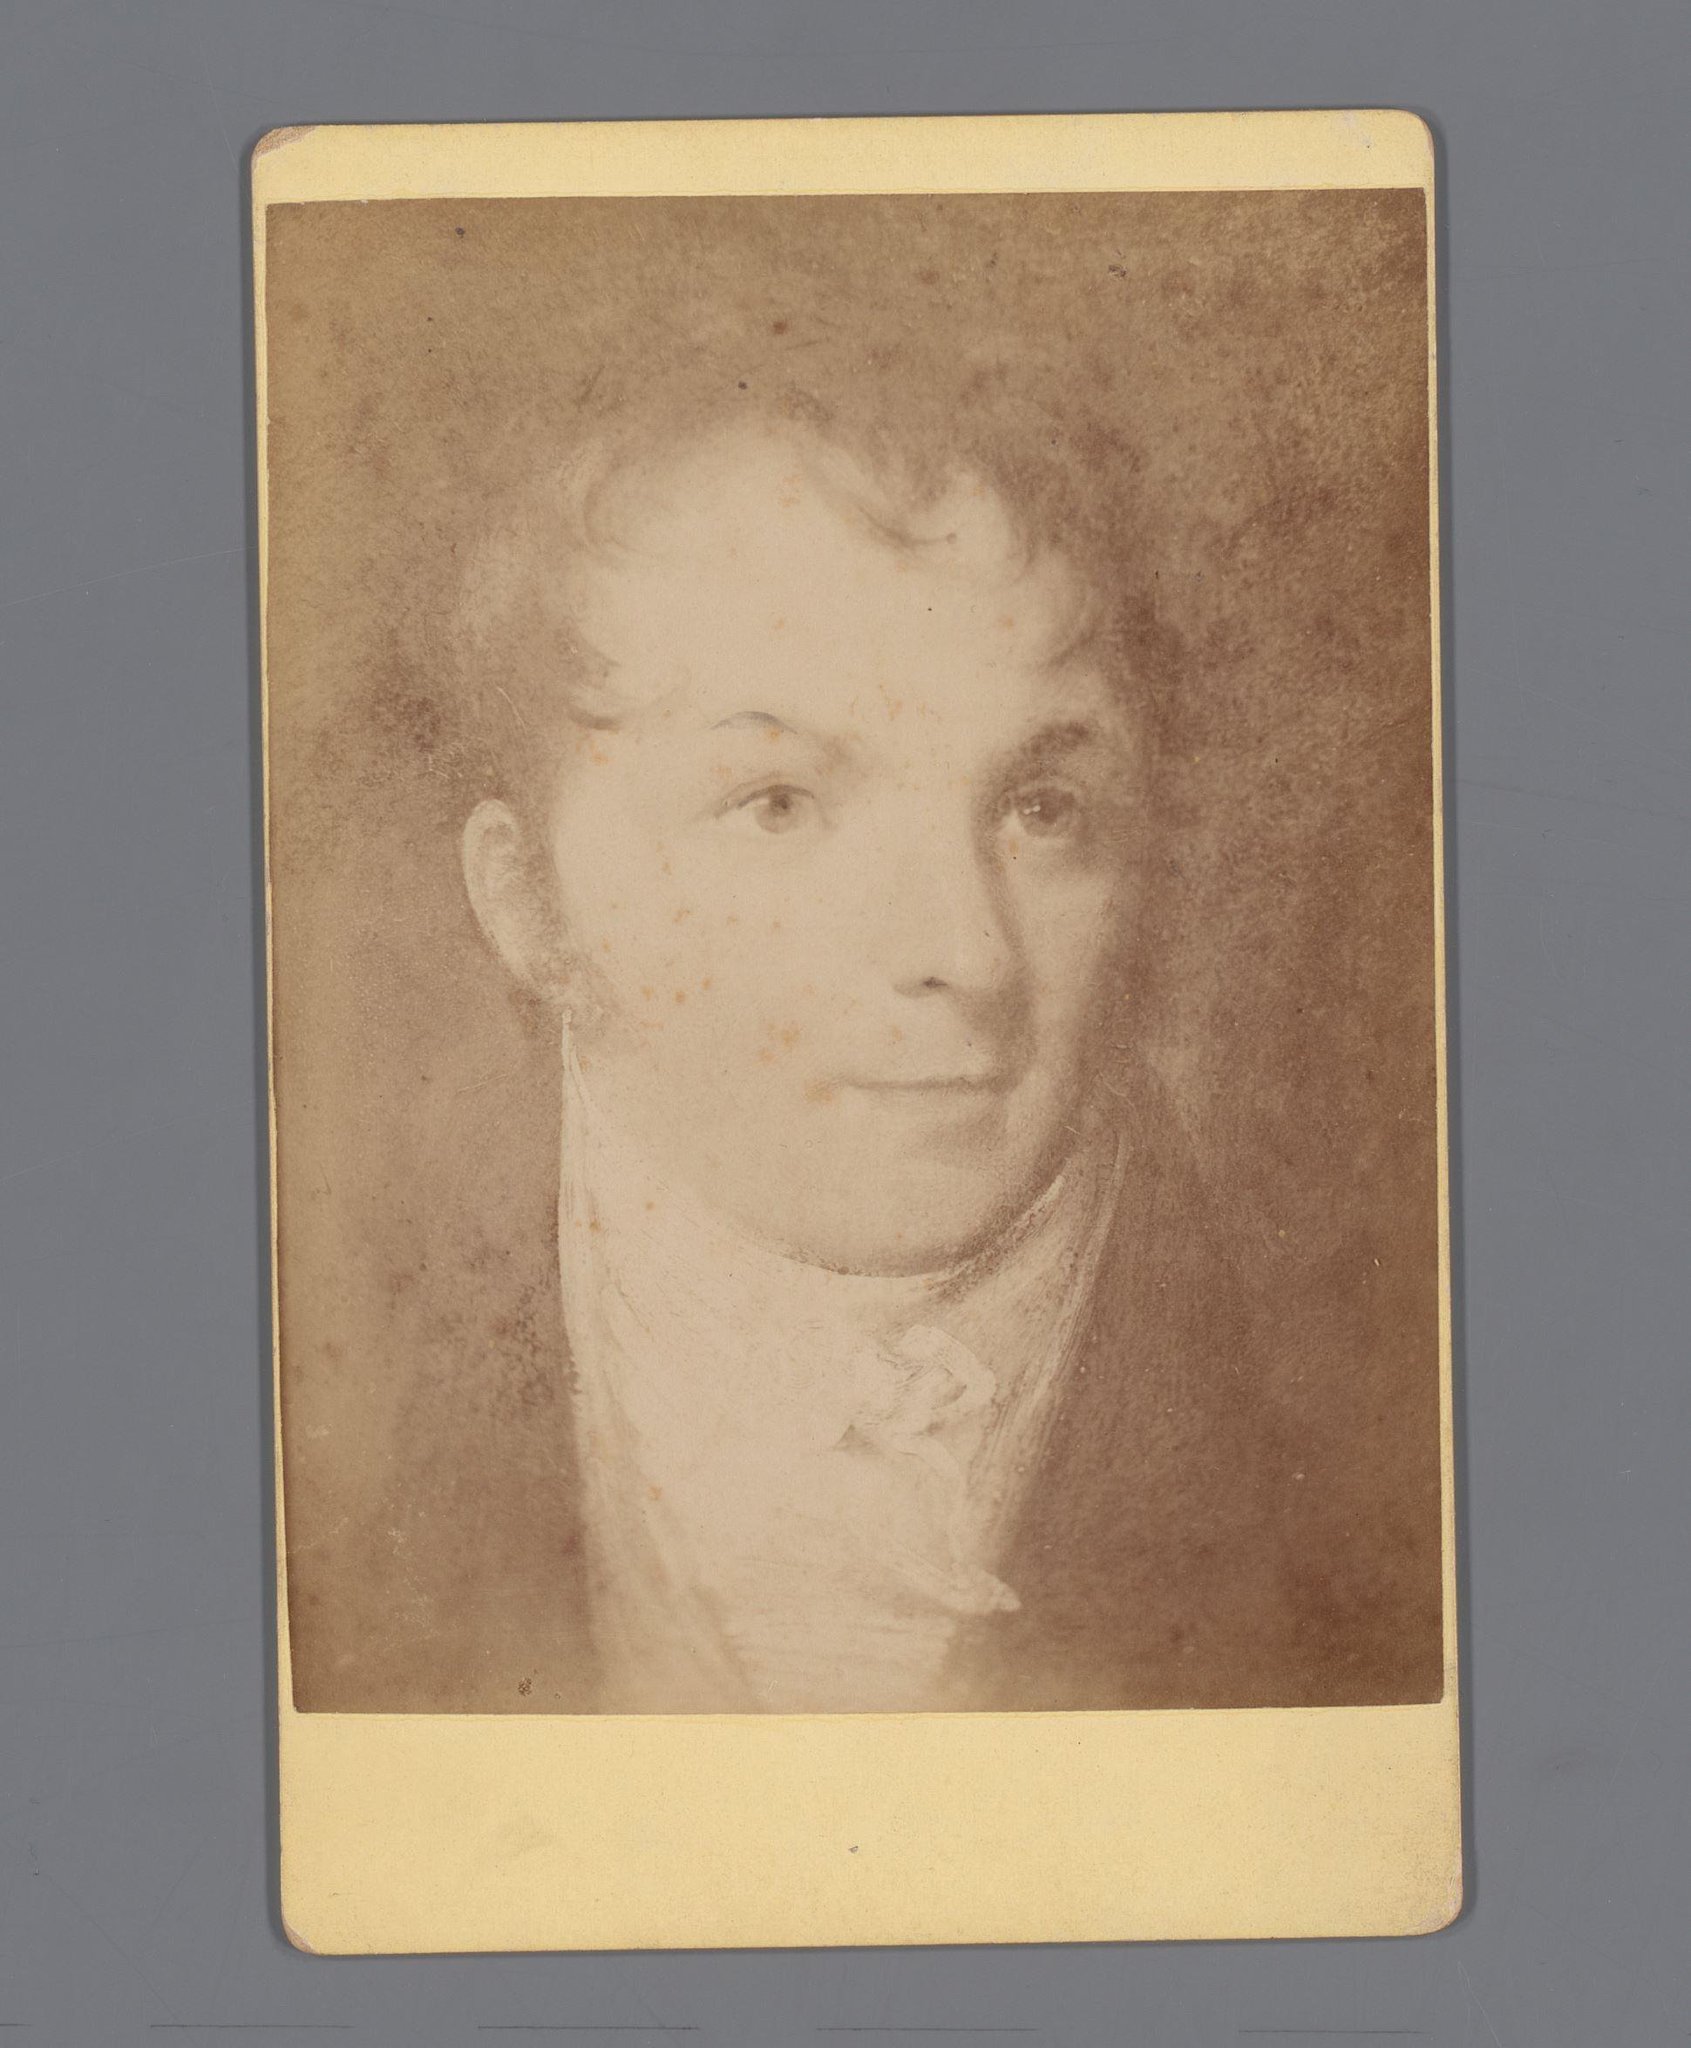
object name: photograph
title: Fotoreproductie van een schilderij van Forster Thomas Proctor, overgrootvader van William Addy Proctor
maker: Anonymous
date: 1880-1900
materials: cardboard, paper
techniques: albumen print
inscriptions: inscription: ‘Forster Thomas Proctor//grandfather of//William Addy Proctor’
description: Fotoreproductie van een schilderij van Forster Thomas Proctor, overgrootvader van William Addy Proctor.